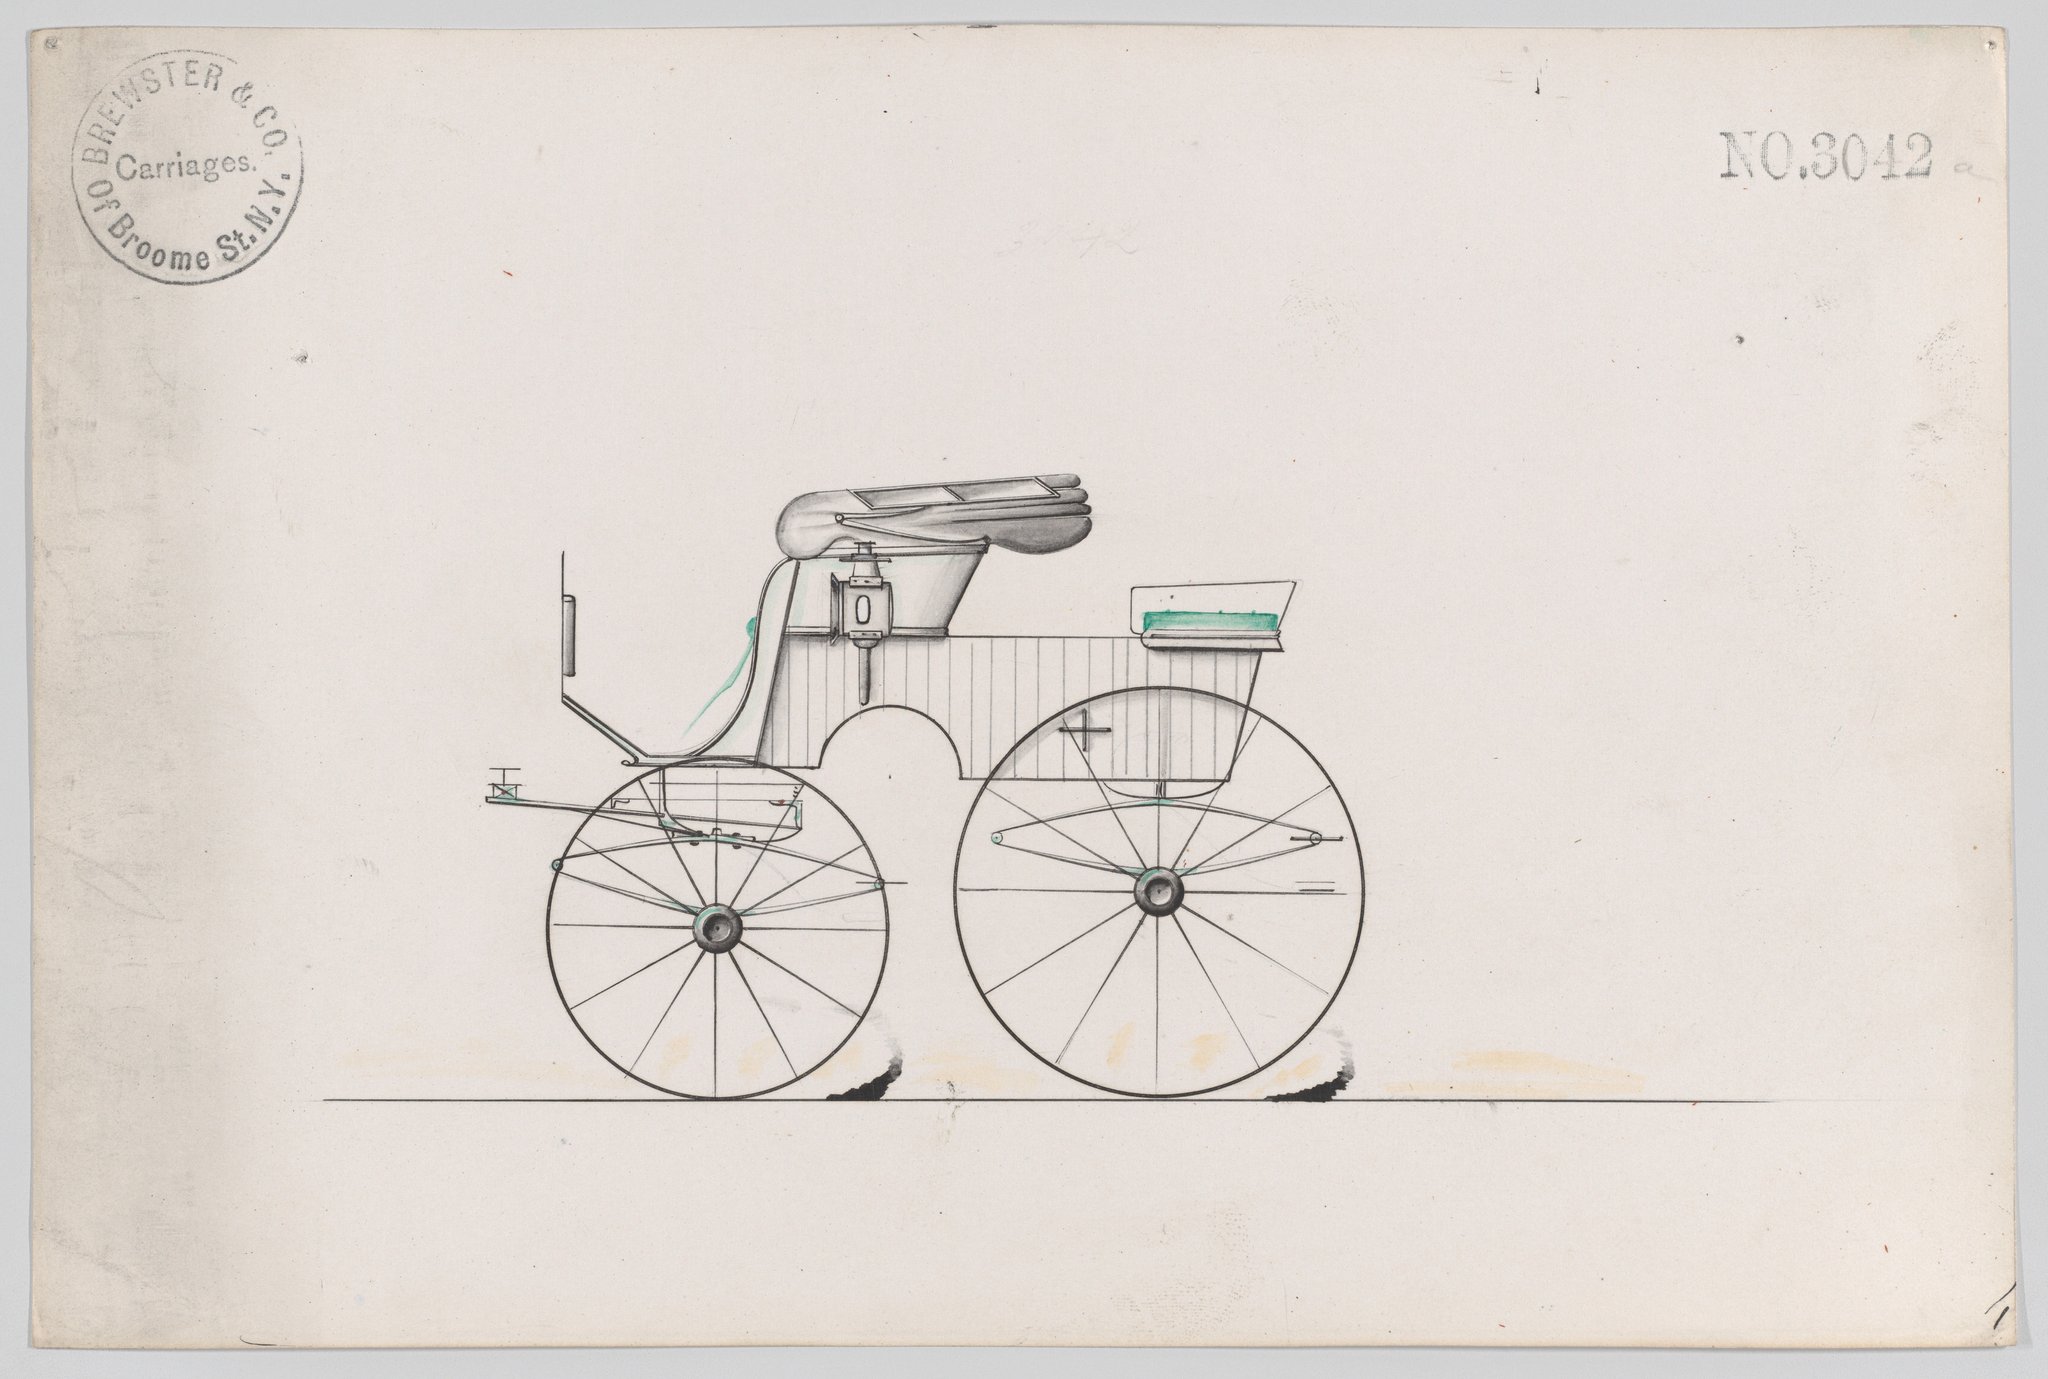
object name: drawing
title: Design for Stanhope Phaeton, no. 3042a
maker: brewster & co.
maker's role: manufacturer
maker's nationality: american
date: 1874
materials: gouache, ink, watercolor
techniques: pen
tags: carriages